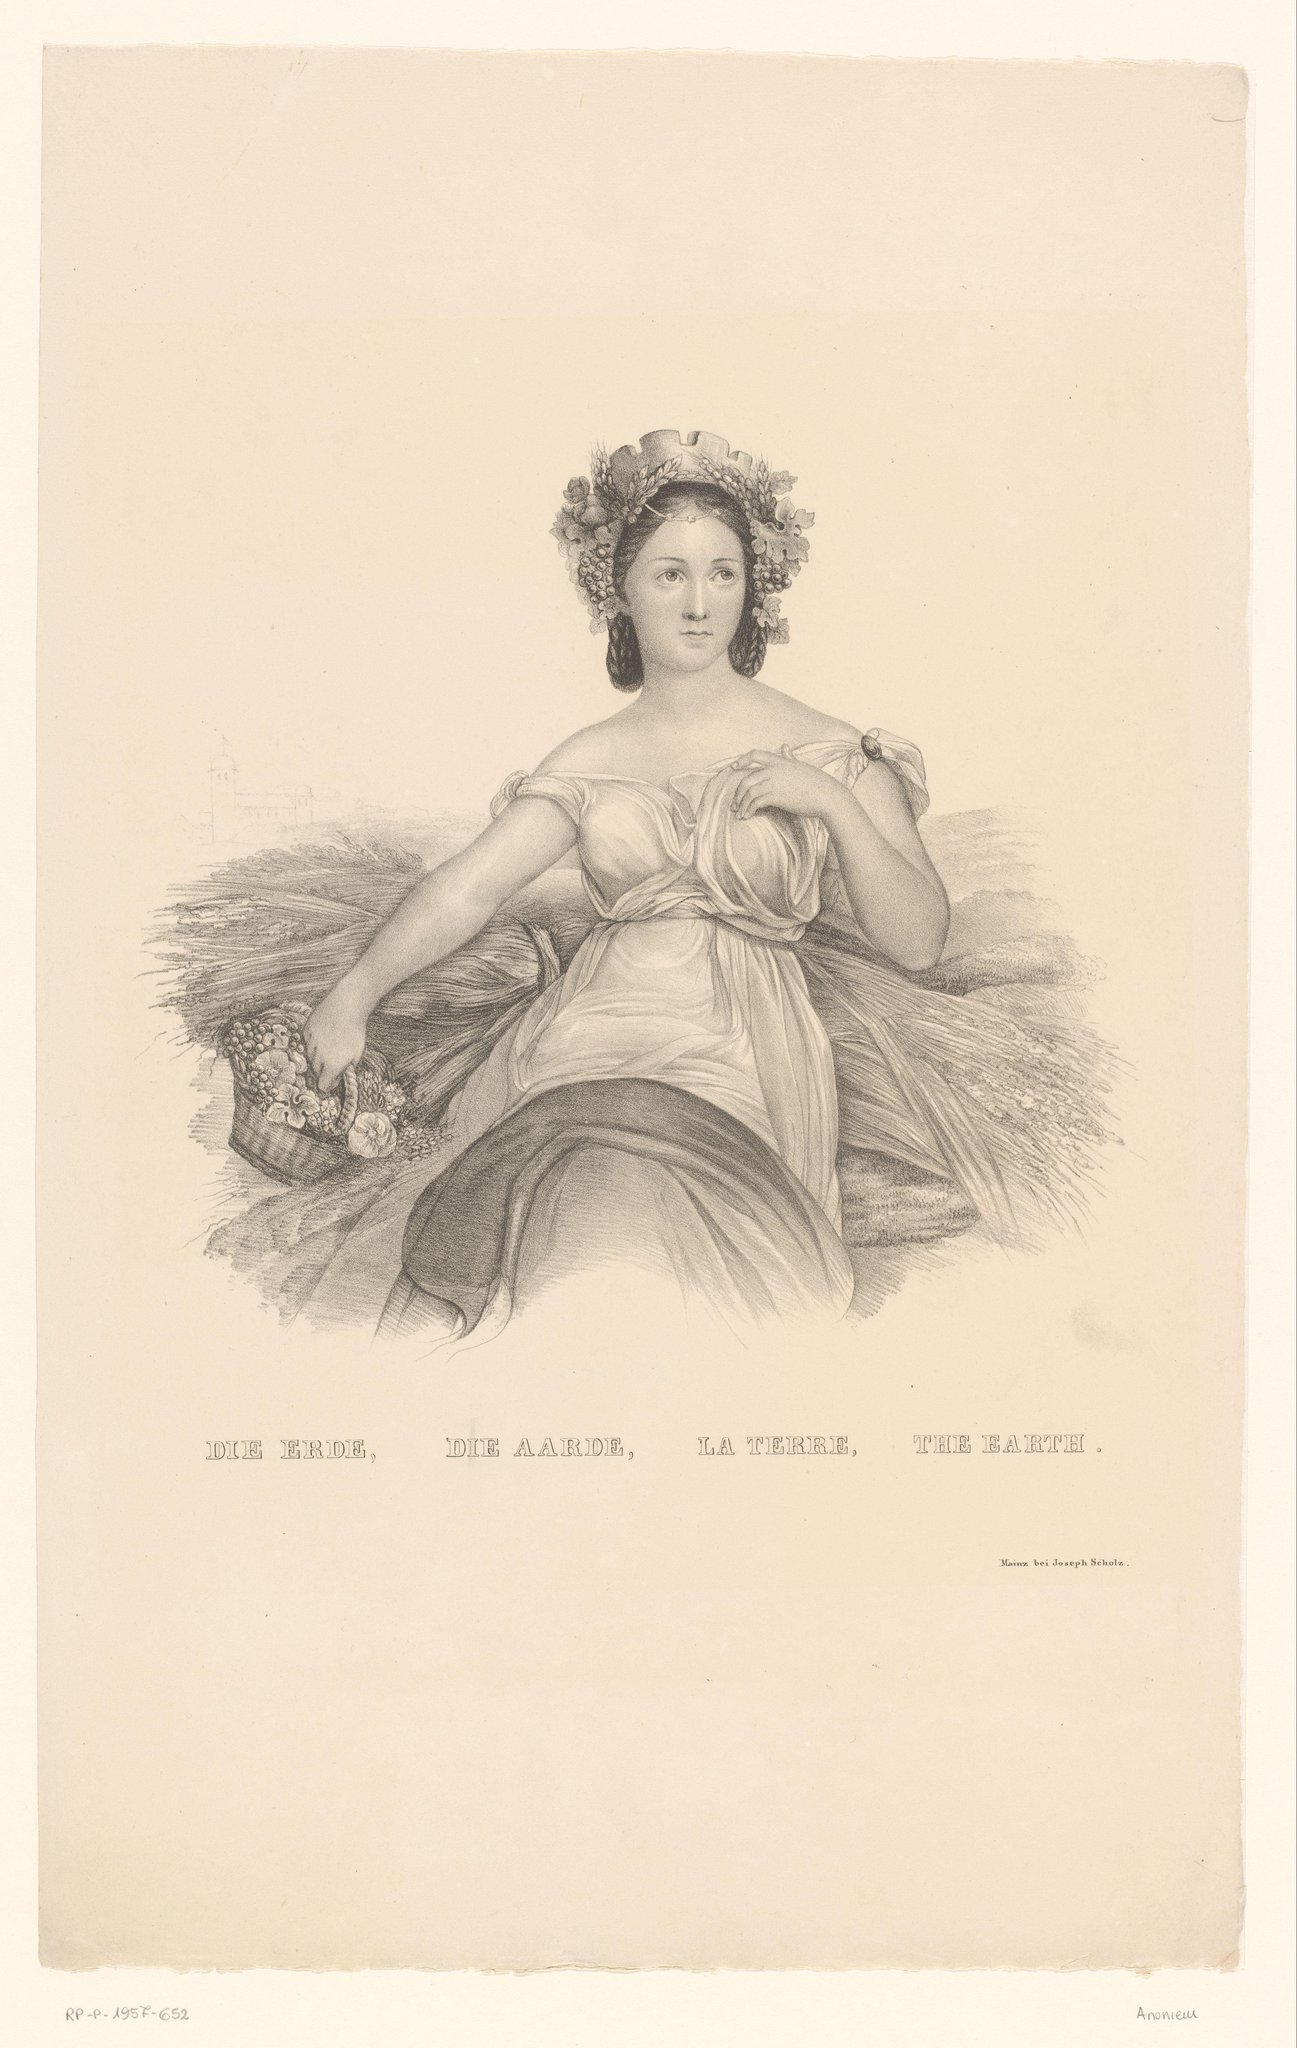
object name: print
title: Aarde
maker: Anonymous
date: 1829-1880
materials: paper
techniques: lithograph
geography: mainz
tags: earth (one of the four elements)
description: Vrouwelijke personificatie van de Aarde met stedenkroon. Zij houdt een mand met bessen en bloemen vast en zit tegen een bos samengebonden tarwe.